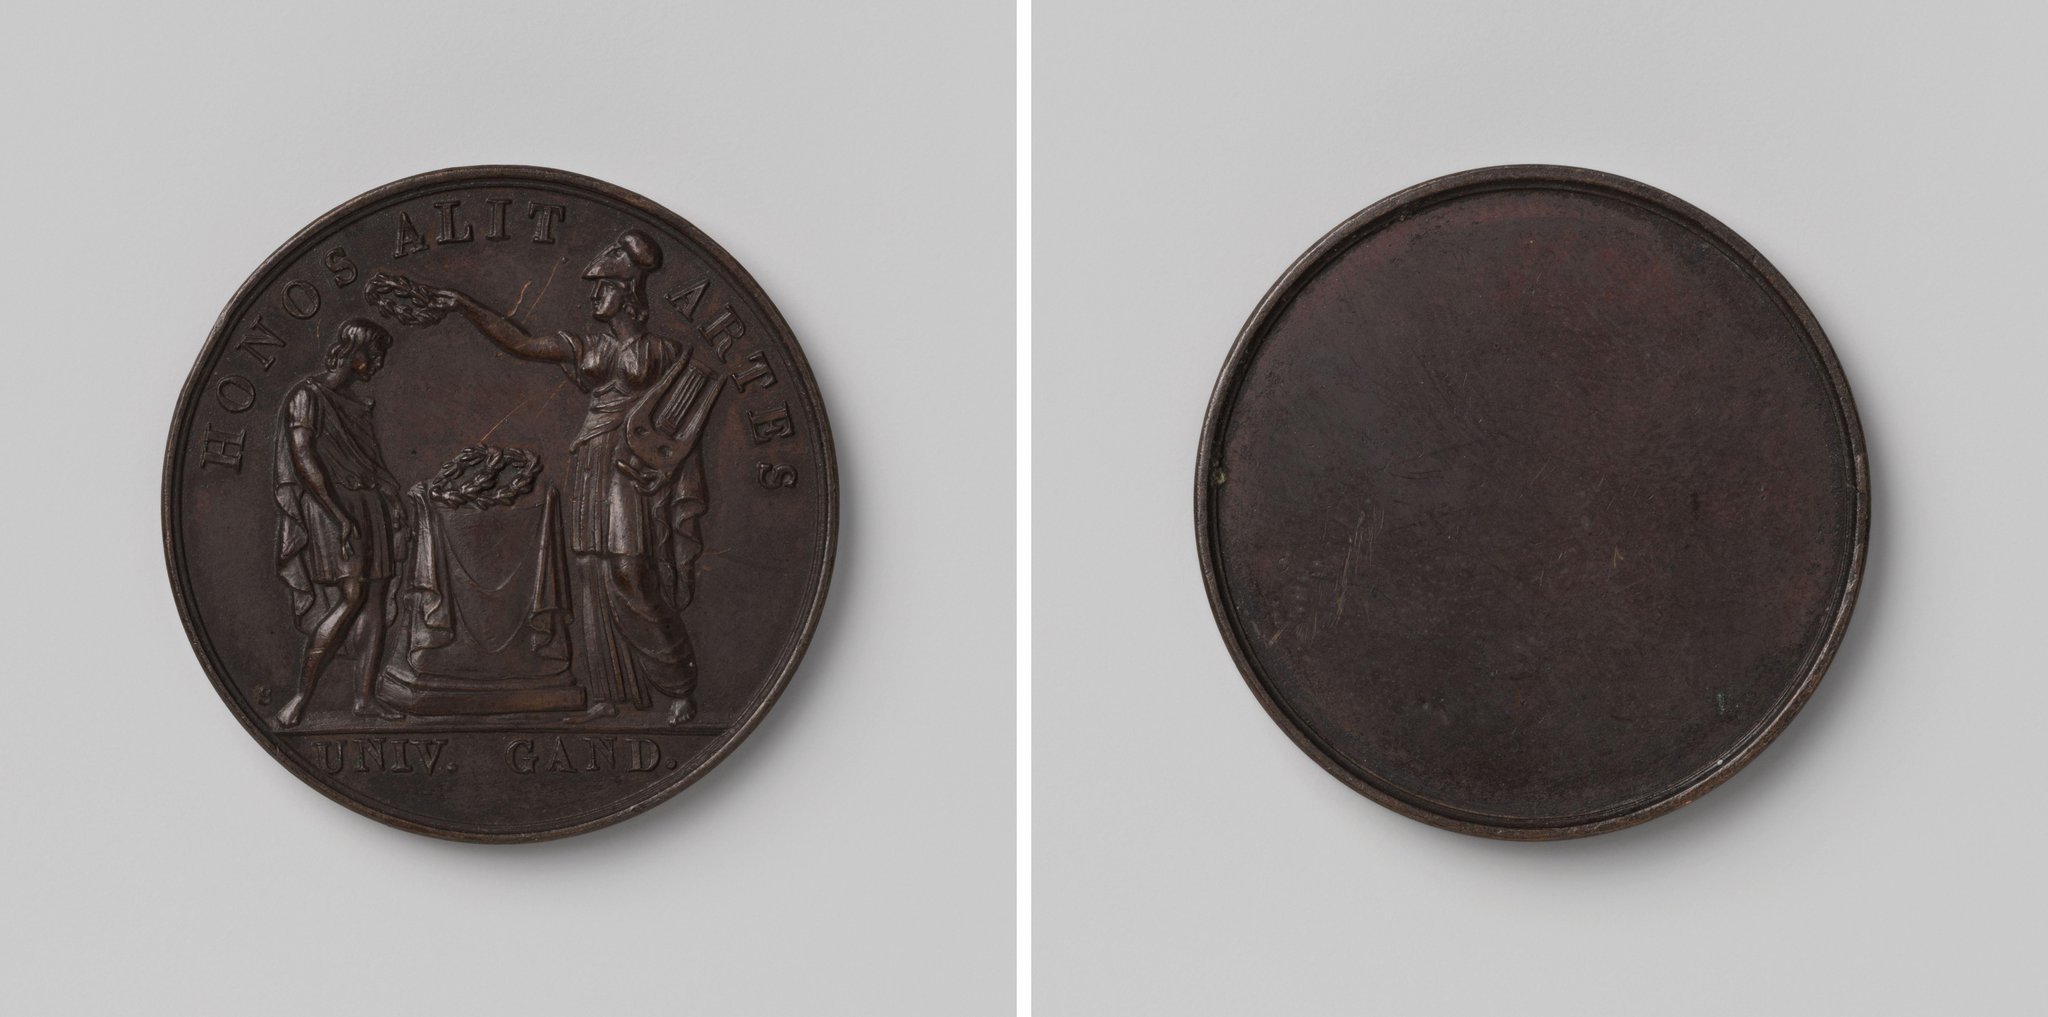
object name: medal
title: Universiteit van Gent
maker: jean henri simon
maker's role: medailleur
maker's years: 1752-1834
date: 1826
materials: bronze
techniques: striking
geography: brussels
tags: ghent